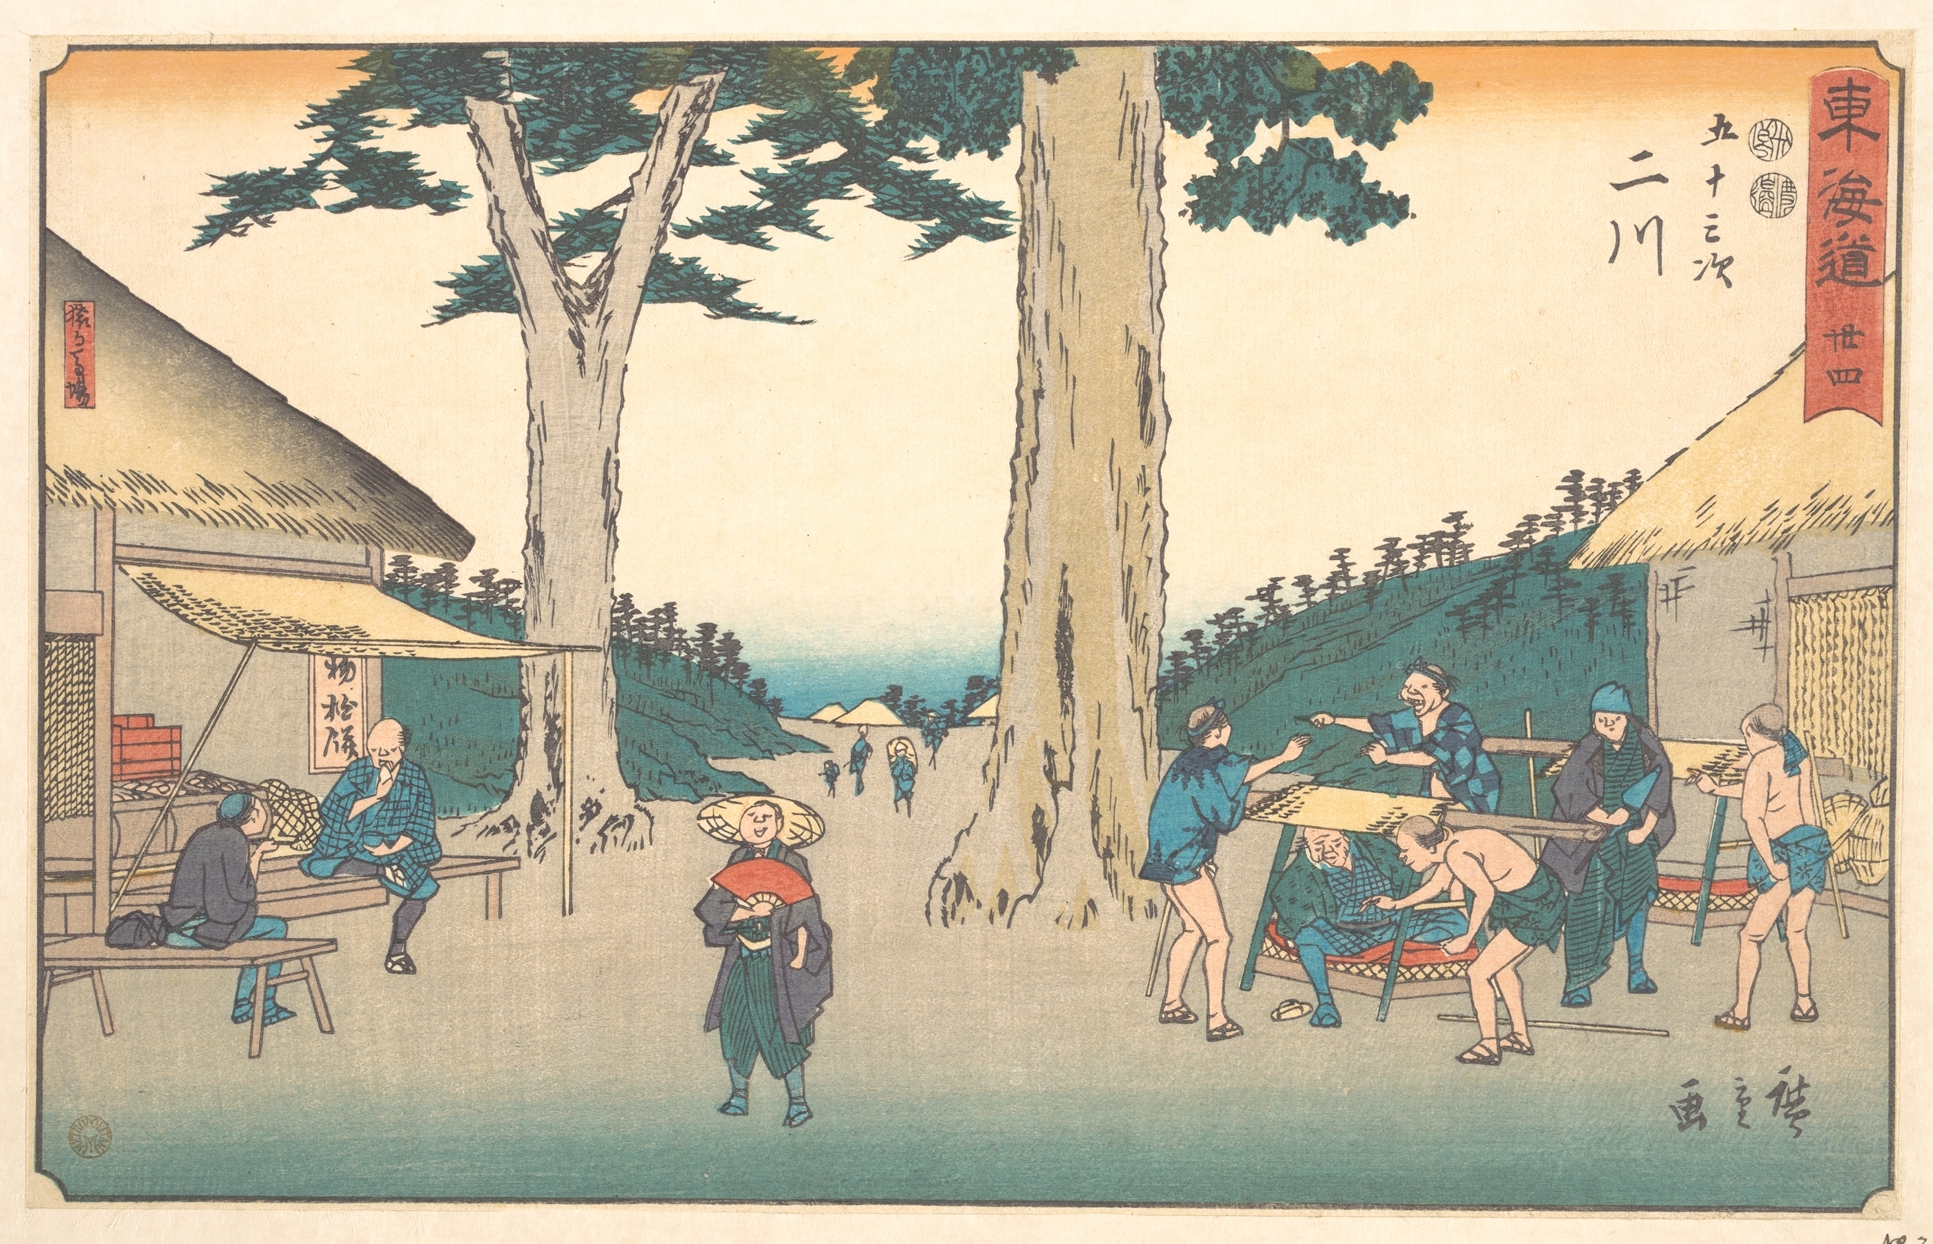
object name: print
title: Futagawa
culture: japanese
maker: utagawa hiroshige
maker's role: artist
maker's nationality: japanese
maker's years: 1797-1858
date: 1840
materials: ink, paper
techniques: woodblock print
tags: men,trees,street scene,markets